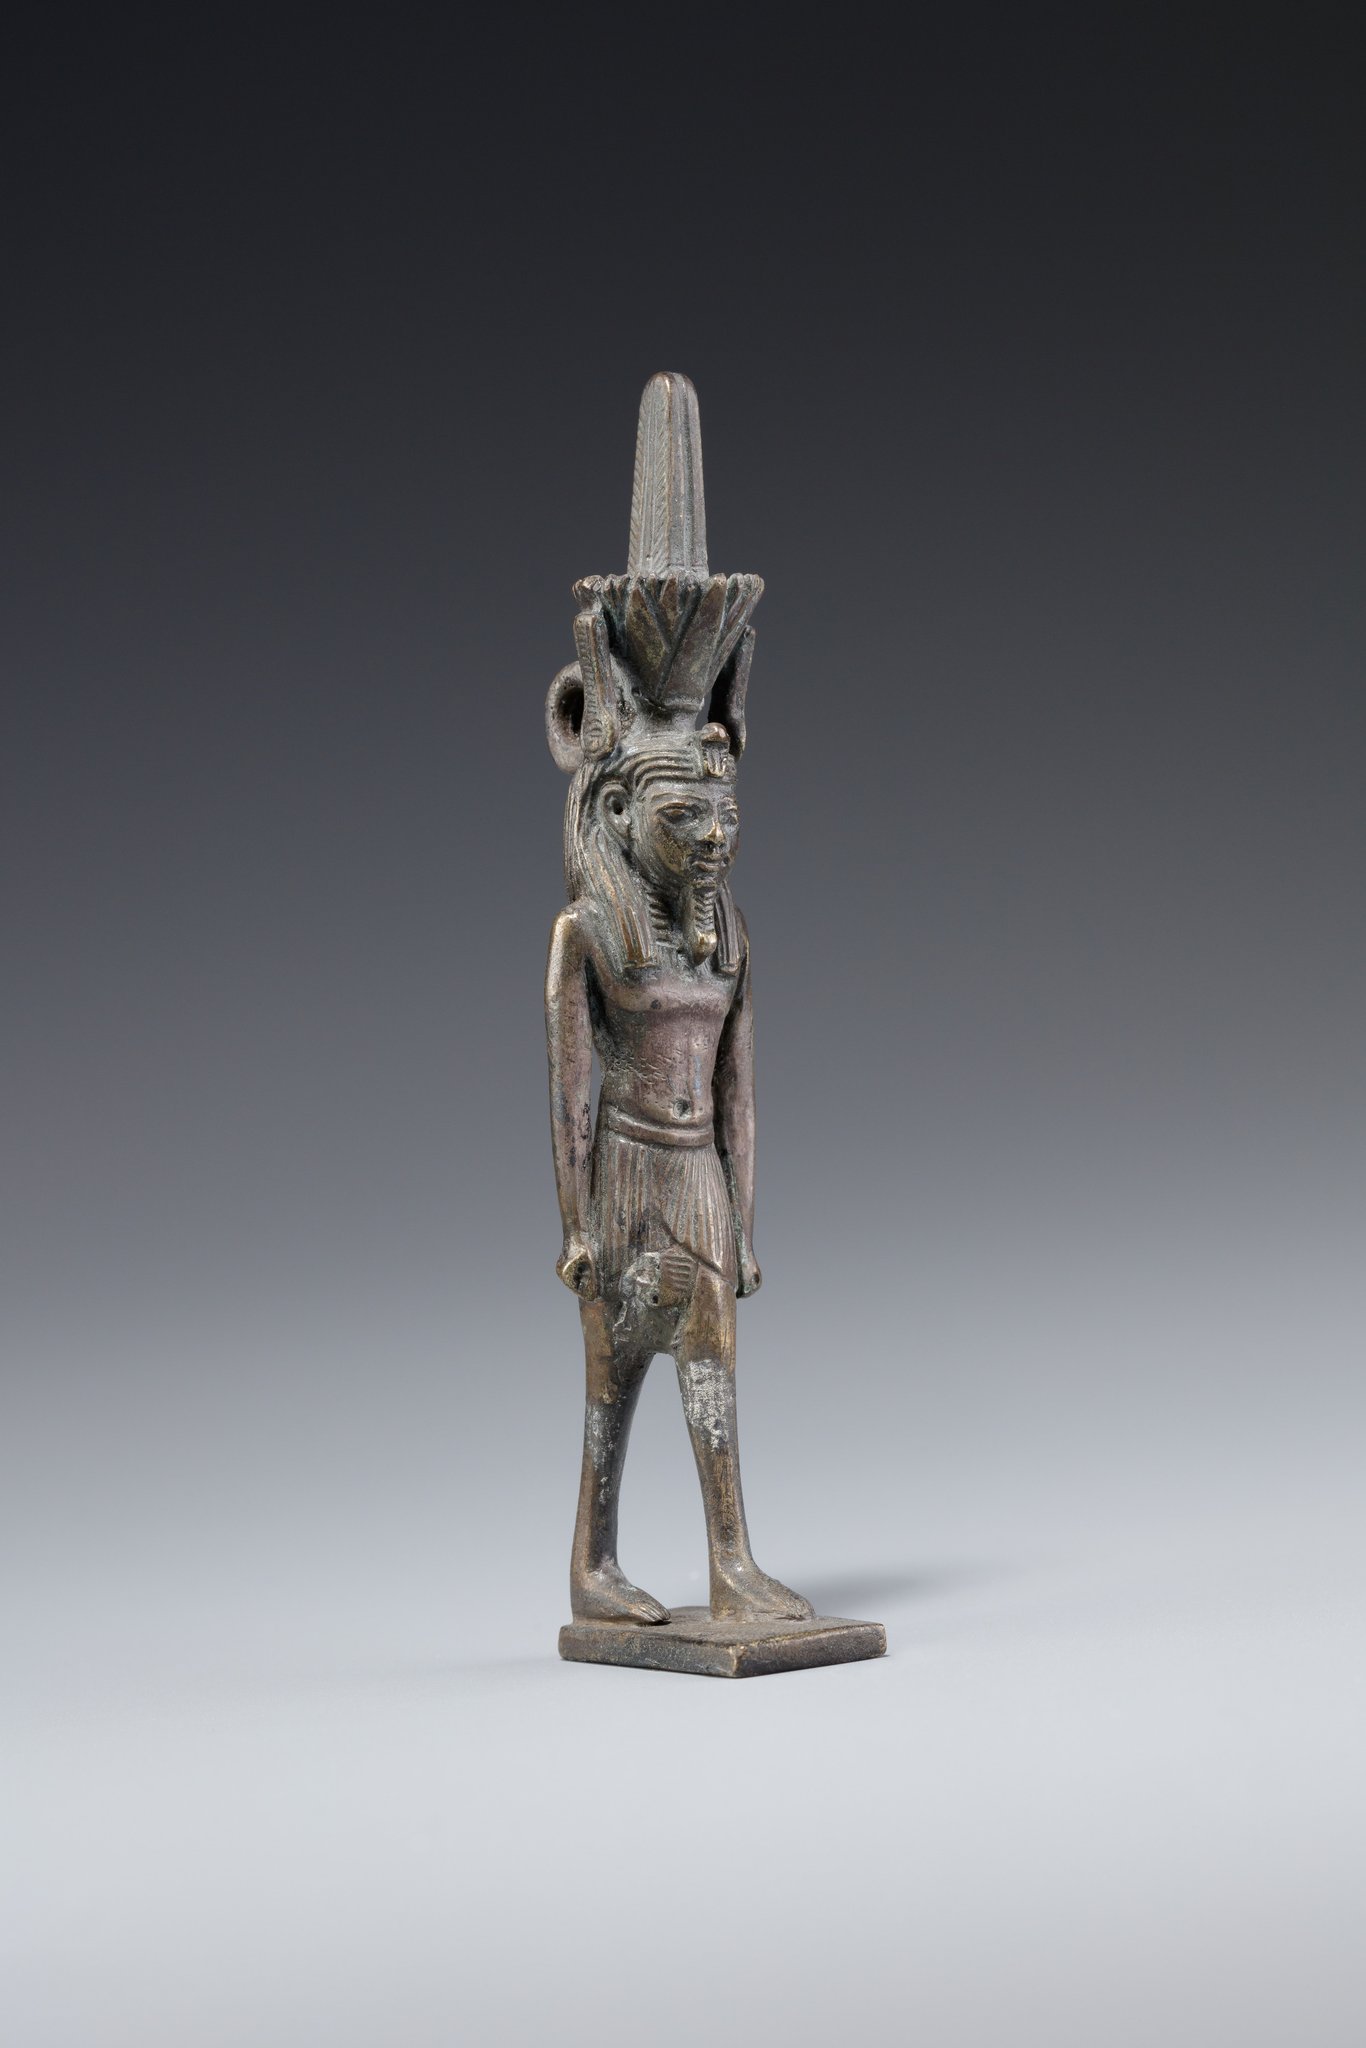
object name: amulet, nefertum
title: Standing Figure of Nefertum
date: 664-332 BCE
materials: silver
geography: egypt